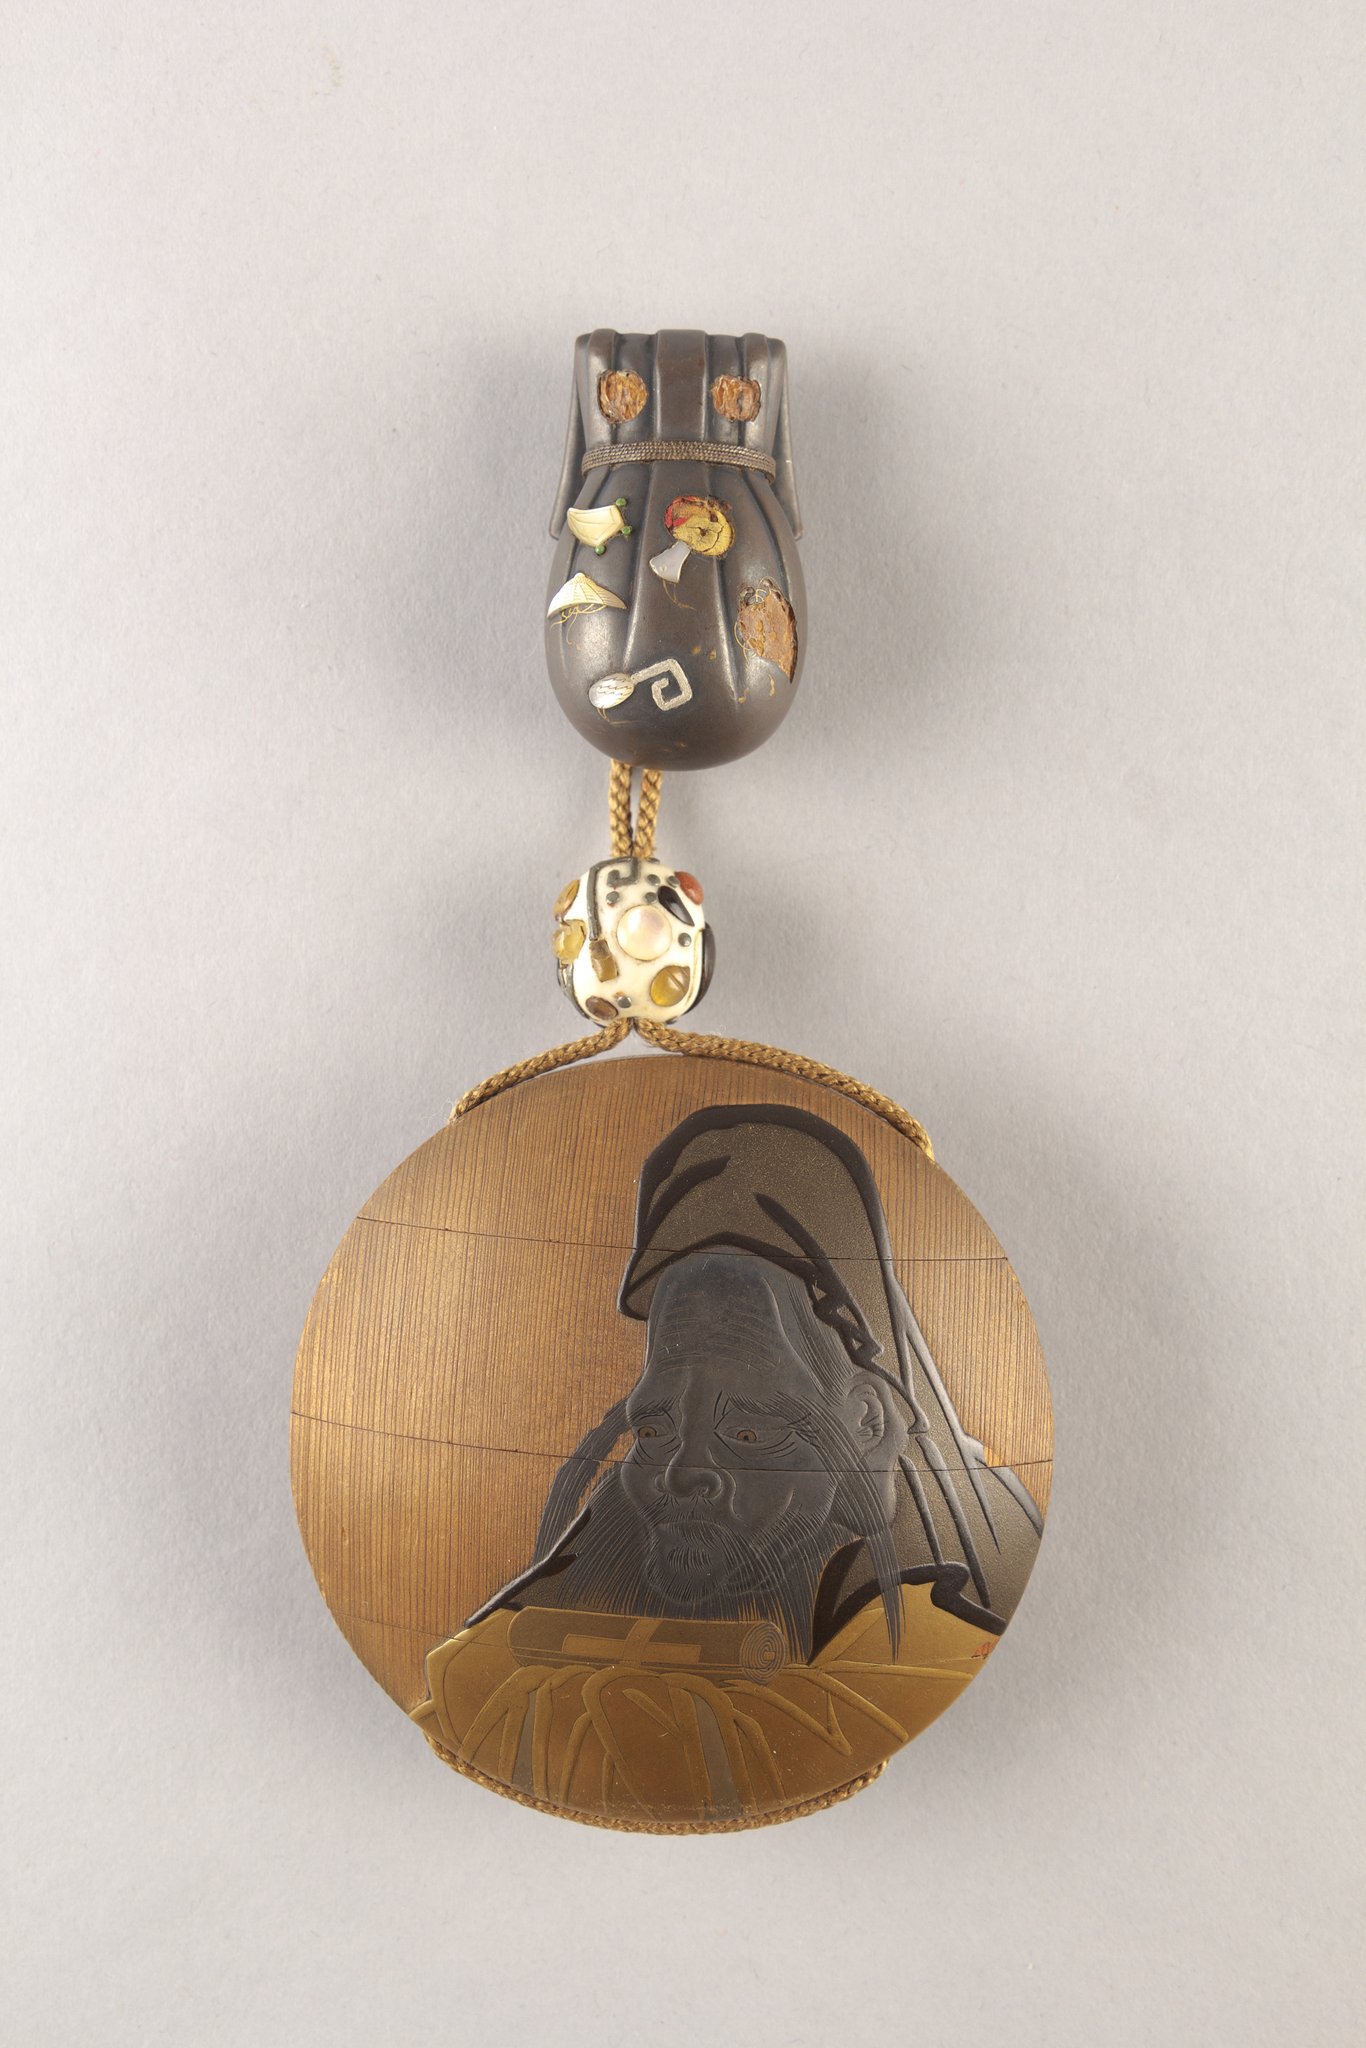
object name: inrō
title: Case (Inrō) with Portrait of a Daruma (obverse); Seal and Inscription (reverse)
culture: japanese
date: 1801-1900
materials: gold, lacquer, silver, wood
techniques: hiramakie, polish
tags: men